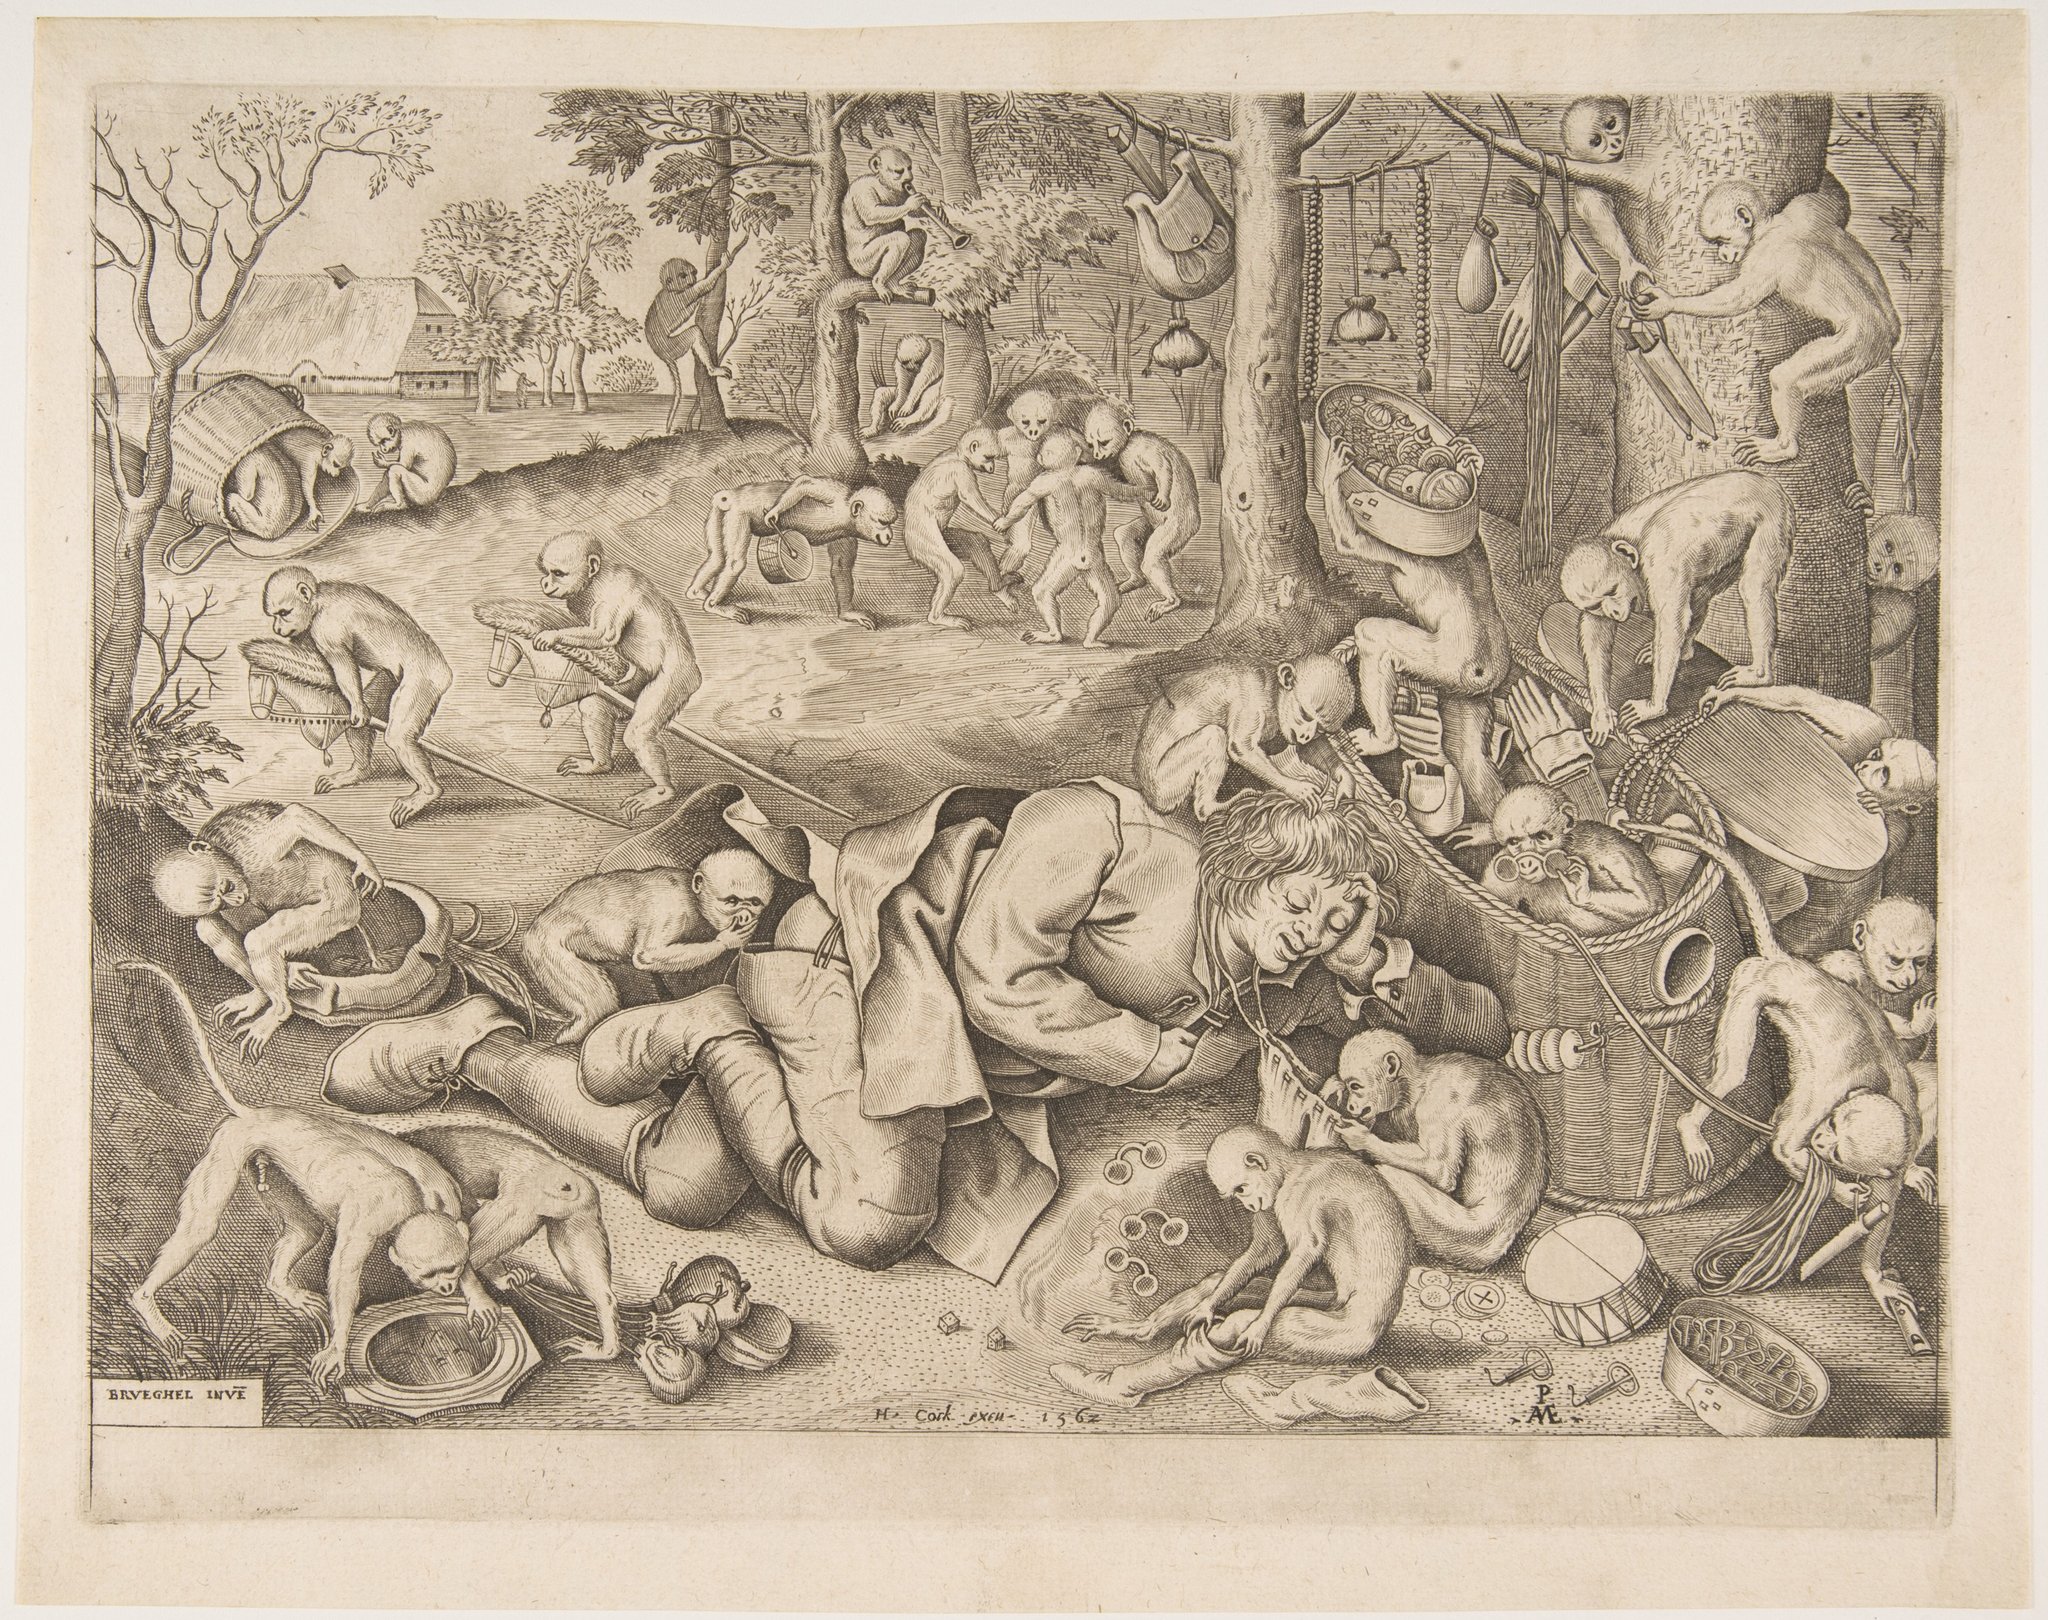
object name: print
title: The Merchant Robbed by Monkeys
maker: pieter van der heyden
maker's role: artist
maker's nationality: netherlandish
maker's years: 1525-1569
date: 1562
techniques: engraving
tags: monkeys,trees,merchants